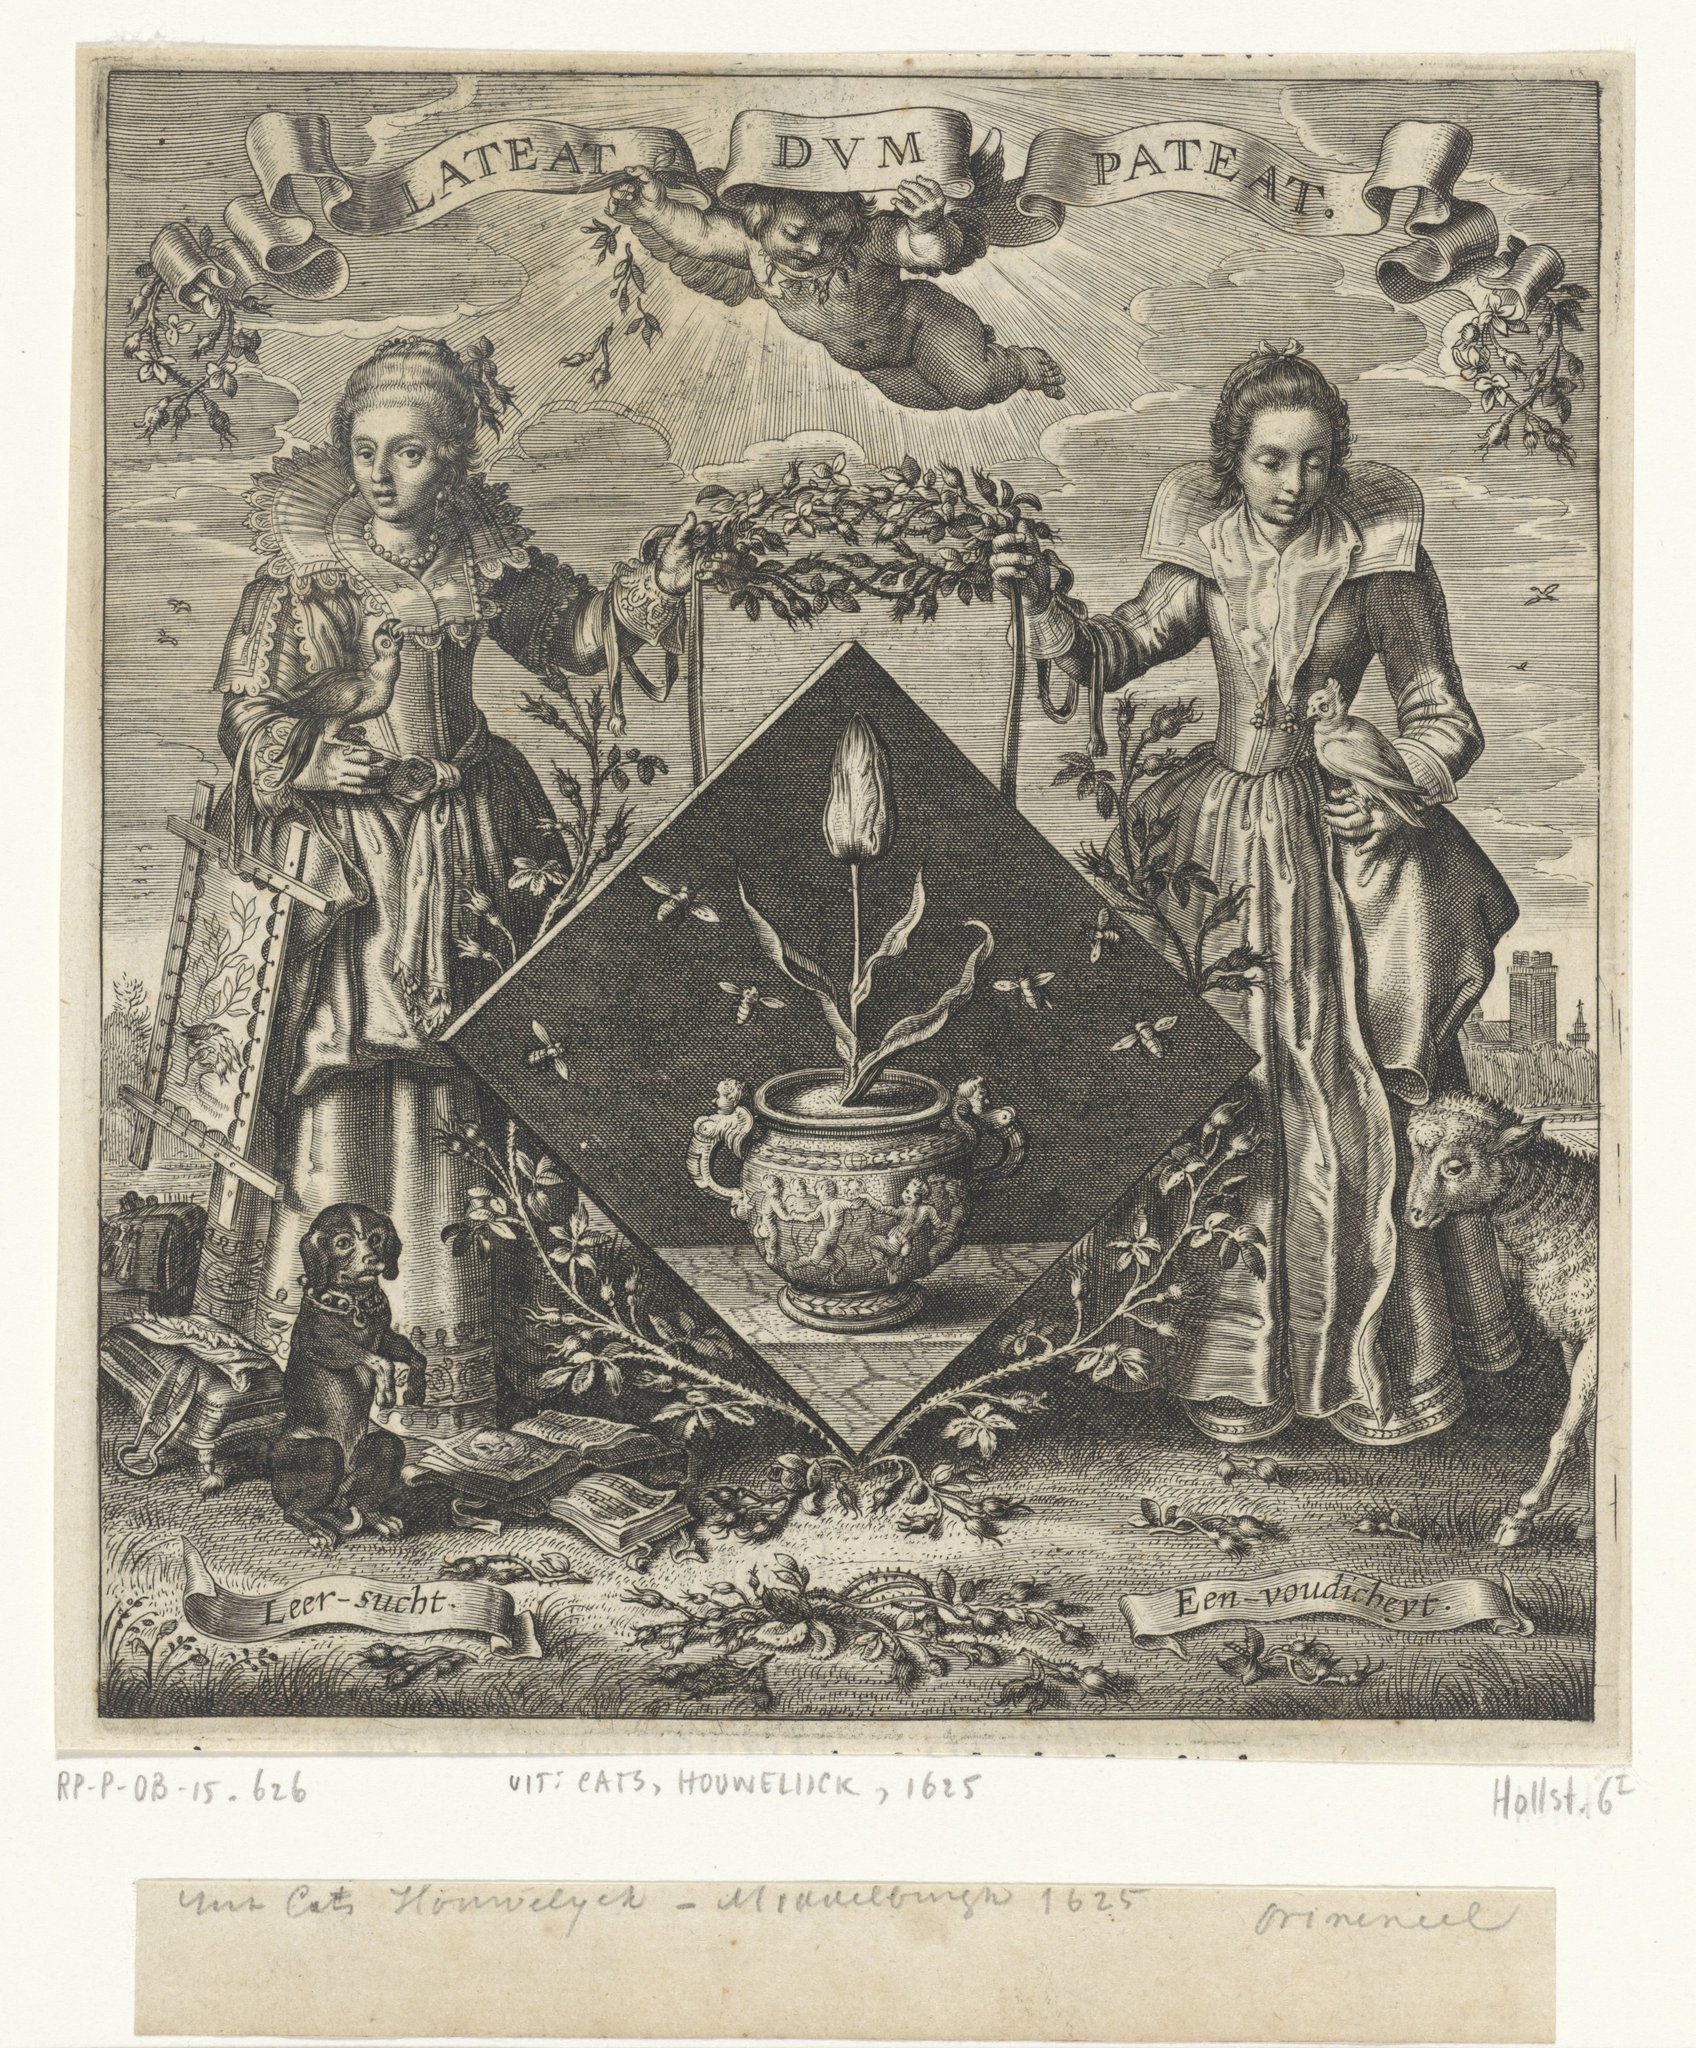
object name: print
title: Titelprent voor: 'Maegde-wapen', onderdeel van J. Cats, Hovwelyck, 1625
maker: Anonymous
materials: paper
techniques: engraving, letterpress printing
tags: printed edition of musical score - cc - out of doors, simplicity; 'simplicità' (ripa), training of performing dog, other birds: dove, lace-making, ornamental birds: parrot, lamb, insects: bee, flowers: tulip, book in which illustrations are essential - mm - book open, embroidery (ornamentation), curiosity, inquisitiveness, desire of knowledge; 'curiosità' (ripa)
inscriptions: collector's mark: Lugt 2228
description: Embleem van een pot met een tulp, omgeven door een zwerm bijen. Het embleem wordt geflankeerd door twee vrouwen, van wie de een 'Leergierigheid' symboliseert en de ander 'Eenvoudigheid'. Zij houden een krans van doornige rozentakken boven het embleem. De rijkgeklede Leergierigheid draagt een papegaai op haar hand en een borduurraam. Aan haar voeten zit een gedresseerd hondje. Op de grond liggen een schaar, kantklossen, een muziekboek en een embleemboek, mogelijk een exemplaar van het Hovwelyck van Cats. Eenvoudigheid draagt meer bescheiden kleding. Op haar hand zit een duif, een lam staat naast haar. Bovenaan draagt een putto een banderolle met het motto "lateat dum pateat".